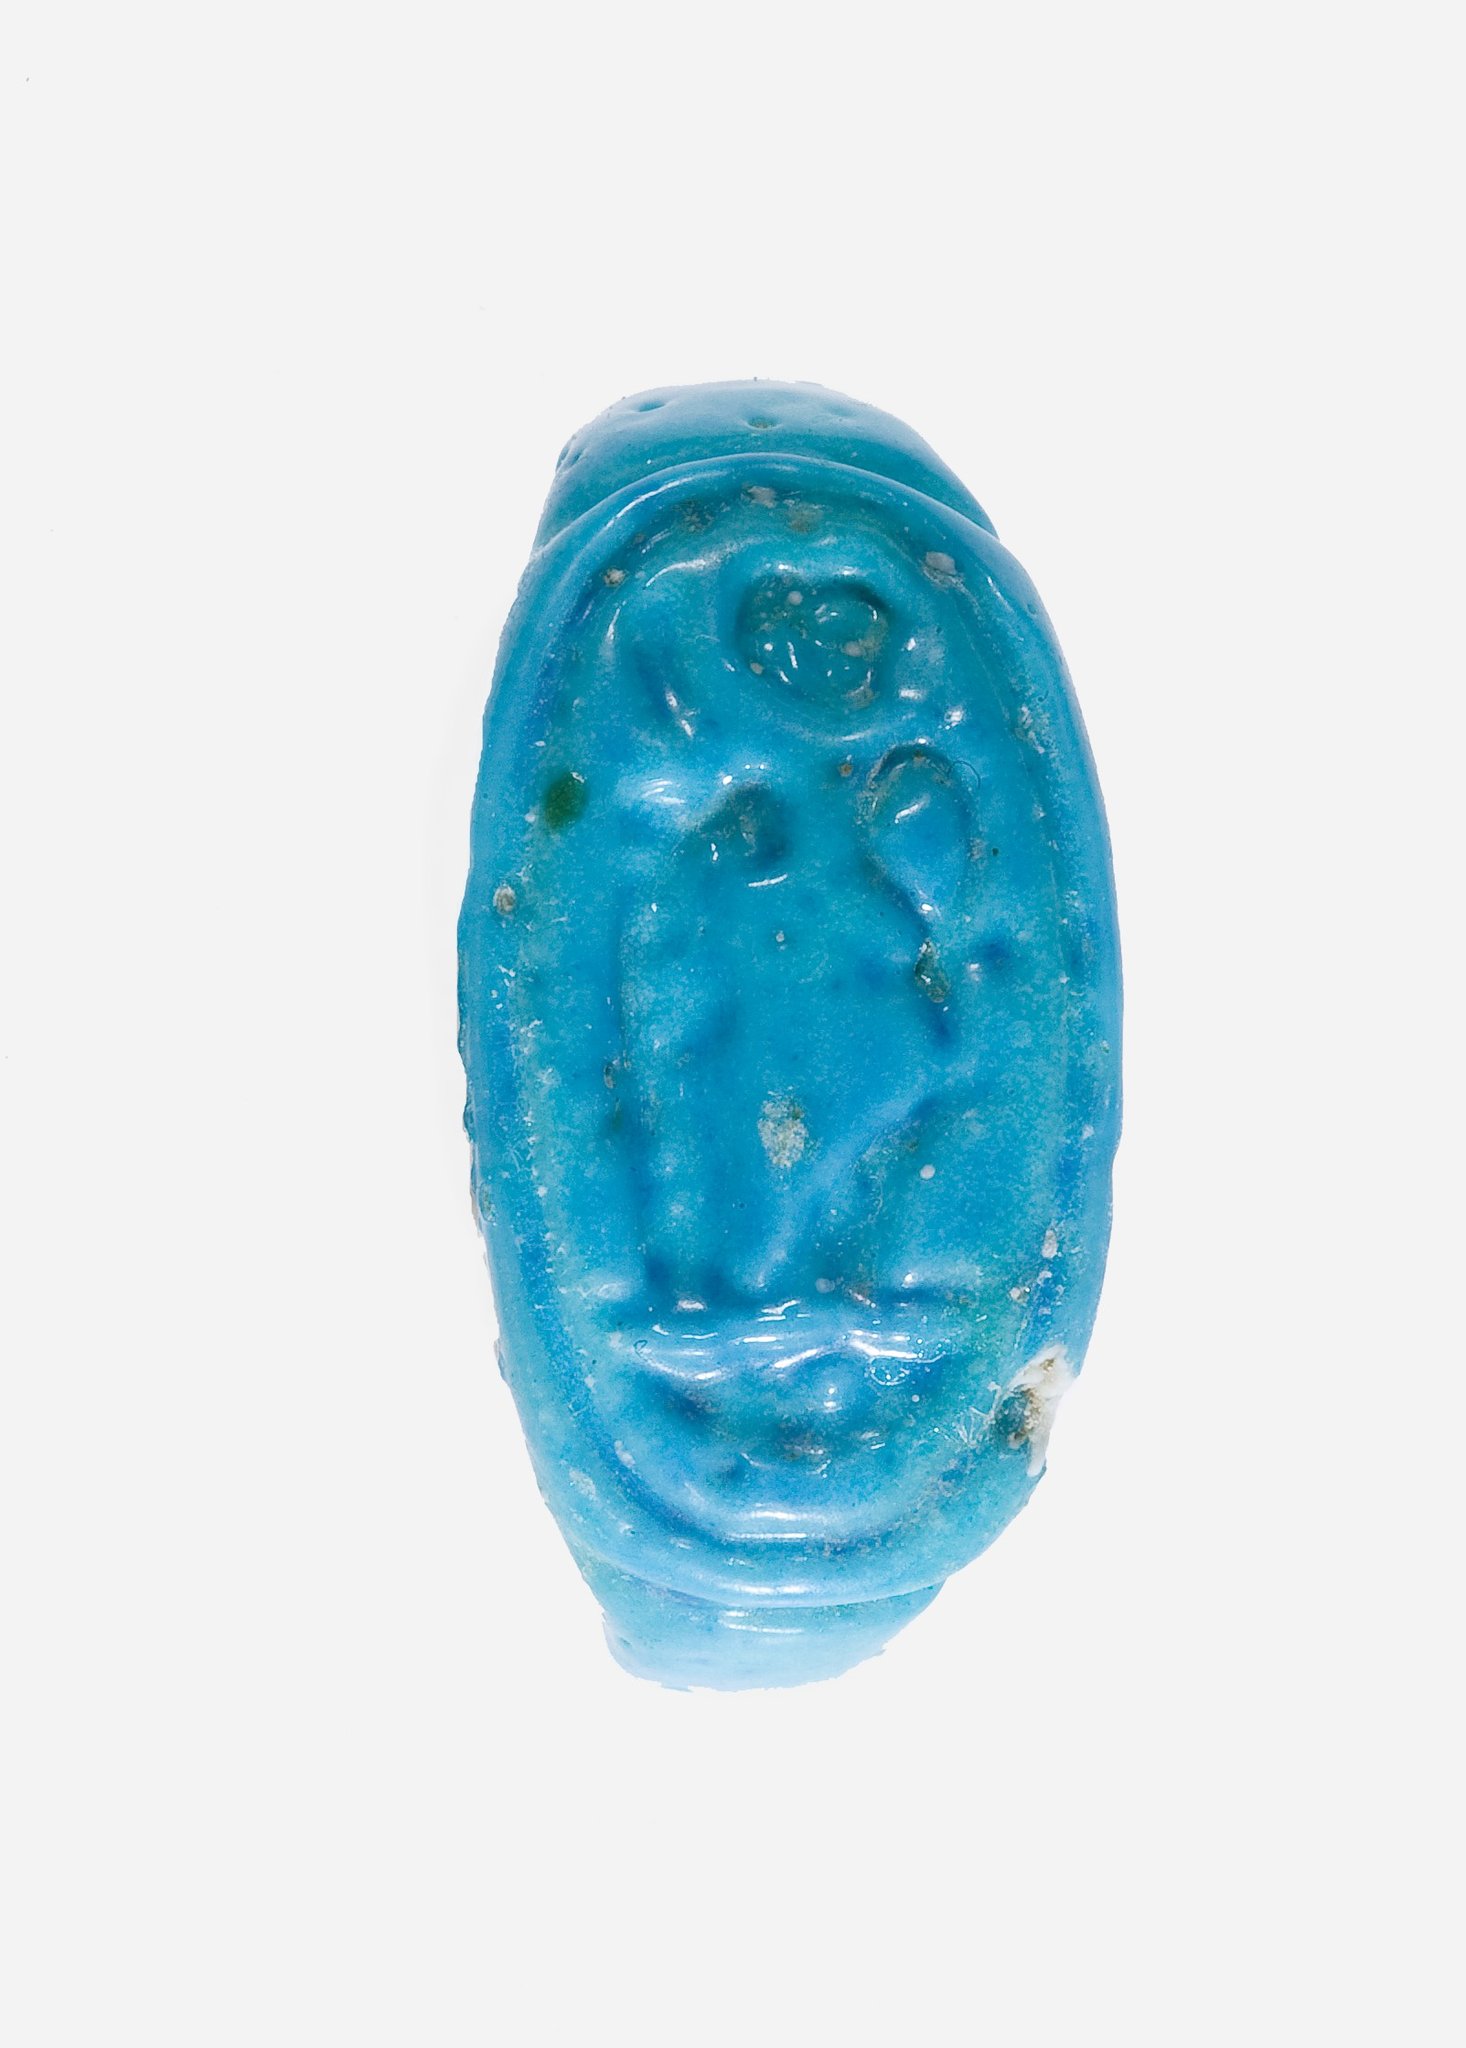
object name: ring, amenhotep iii, nebmaatre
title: Ring Inscribed with the Throne Name of Amenhotep III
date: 1390-1352 BCE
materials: faience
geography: egypt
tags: hieroglyphs